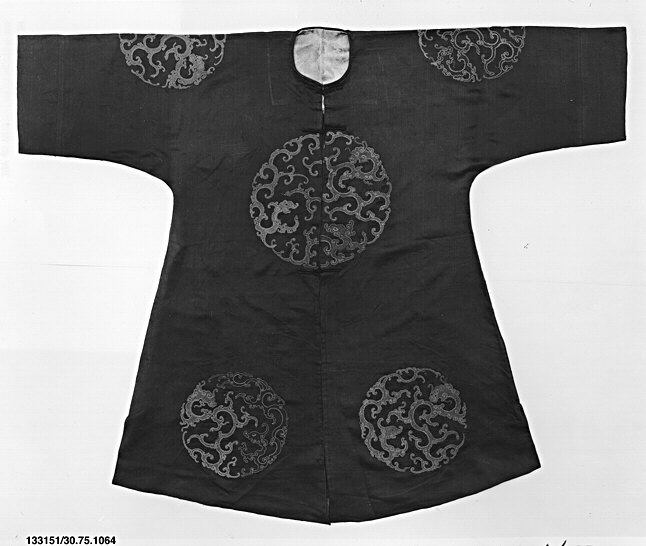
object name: coat, ceremonial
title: Woman's Outer Coat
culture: chinese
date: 1701-1833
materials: silk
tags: dragons